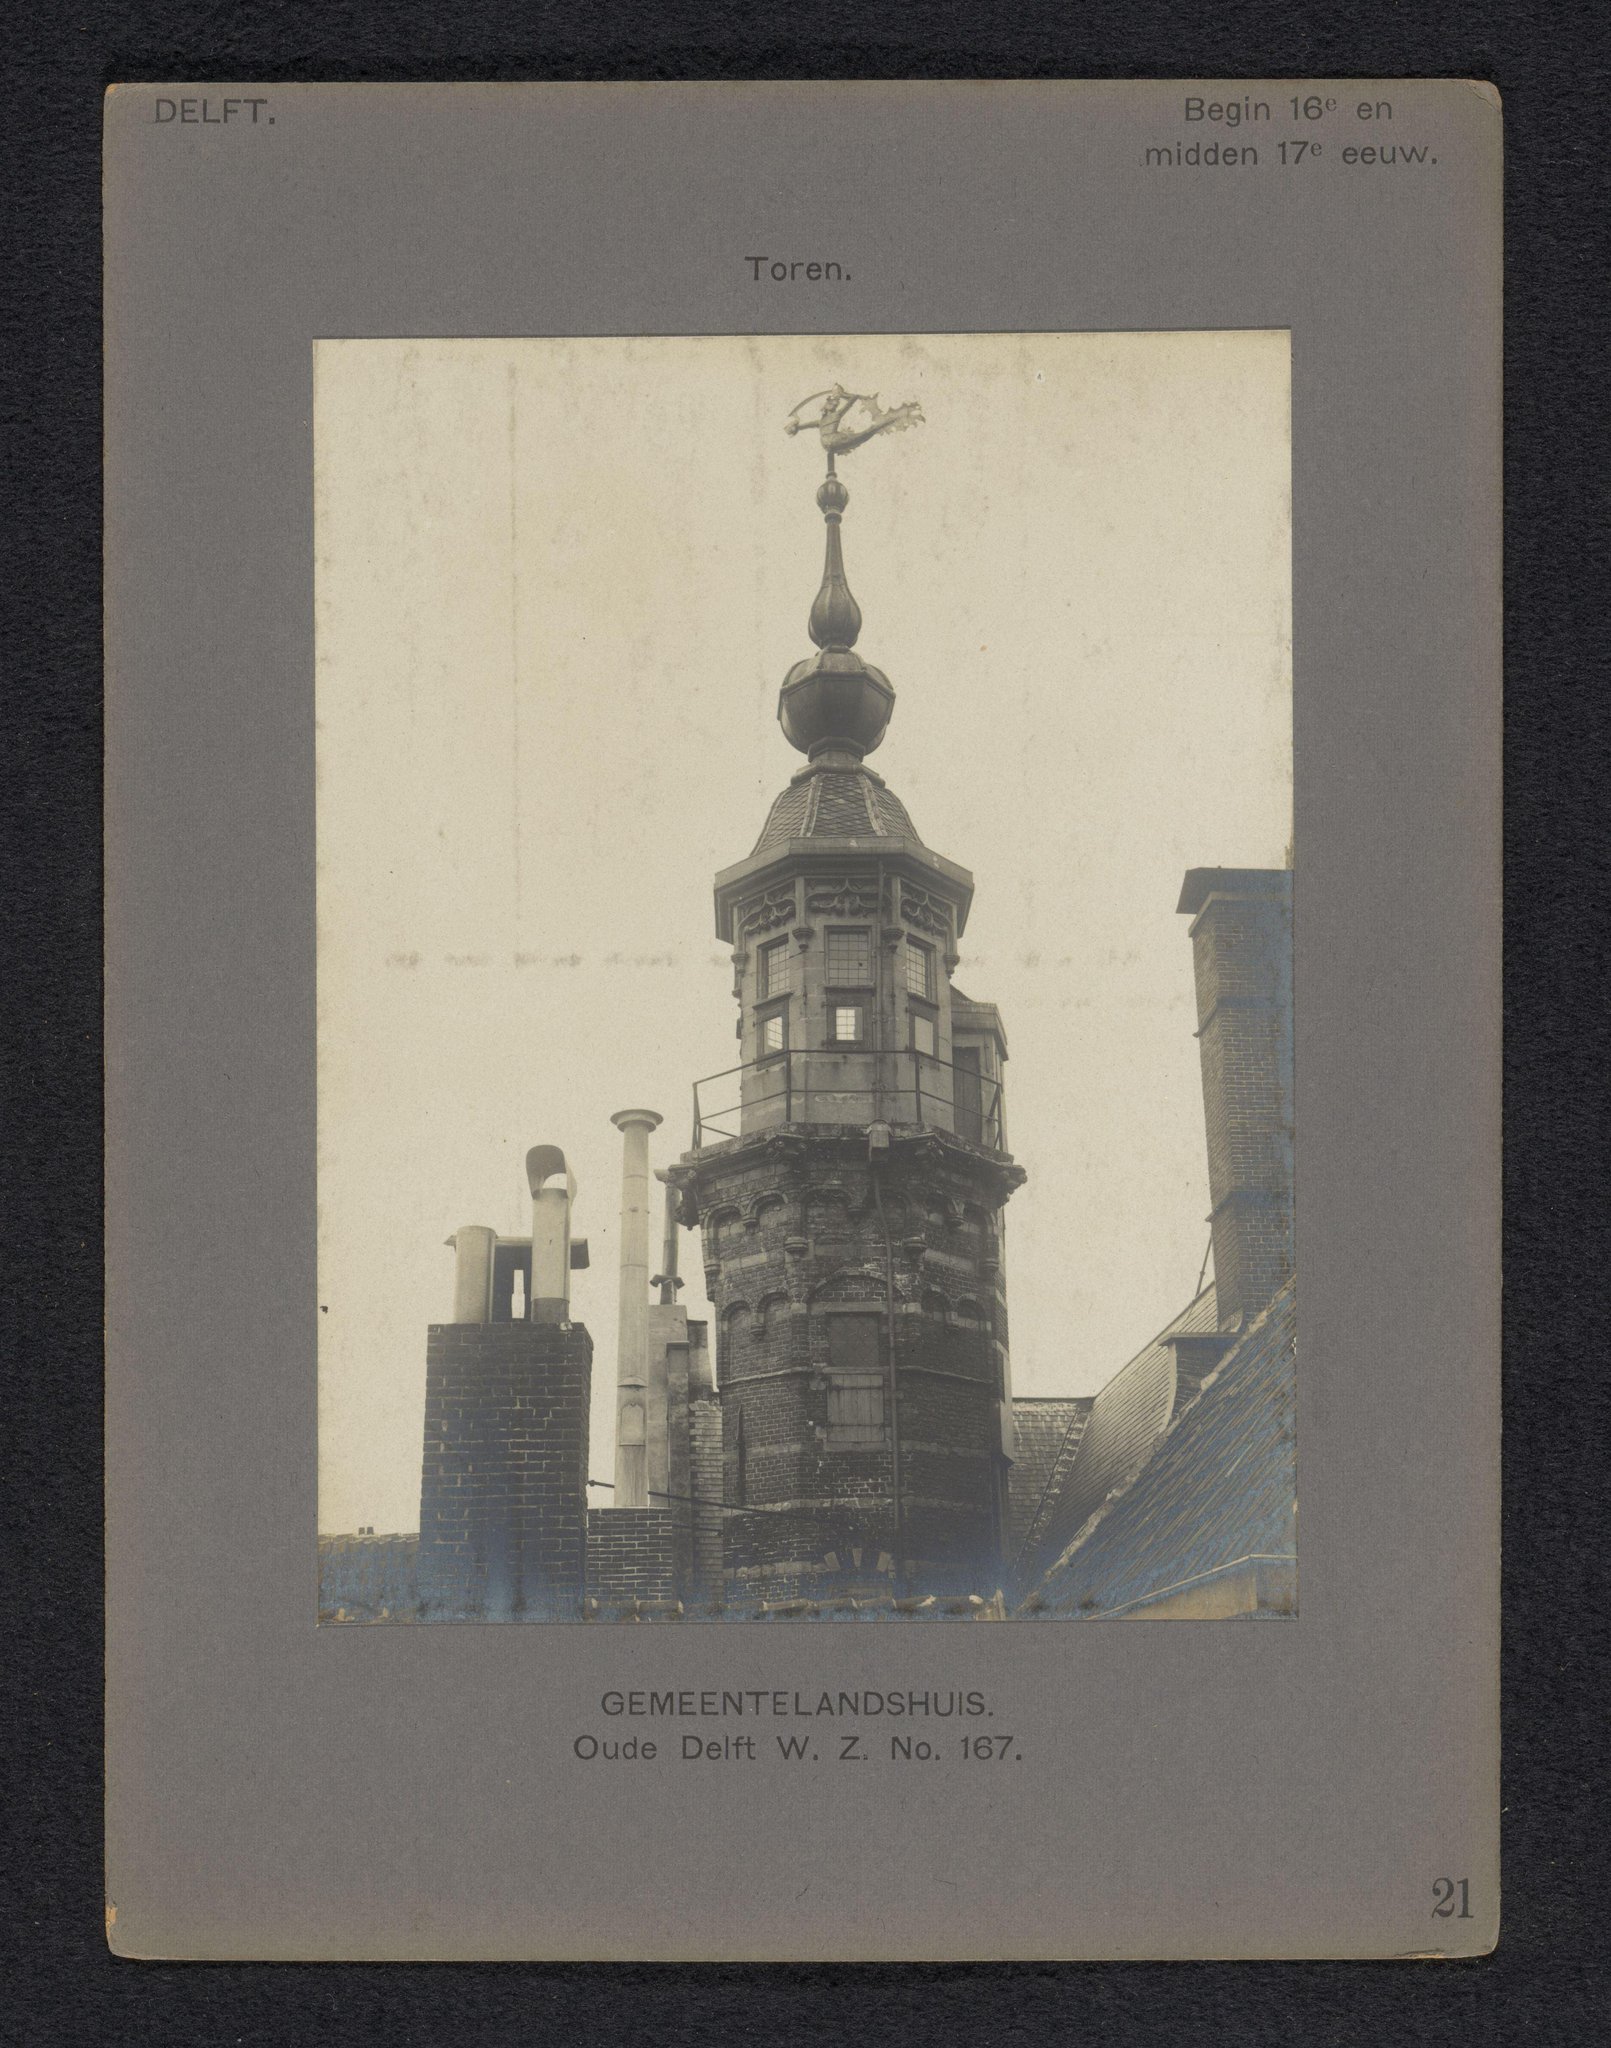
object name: photograph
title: Toren van het Gemeenlandshuis aan de Oude Delft in Delft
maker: Anonymous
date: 1900-1904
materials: cardboard, photographic support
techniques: gelatin silver print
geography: delft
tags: weather-vane, tower (of house or building)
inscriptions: number: ‘21’, inscription: ‘Het recht van reproductie dezer photo's wordt door den Uitgever voorbehouden.’, inscription: ‘Delft. Begin 16e midden 17e eeuw.’